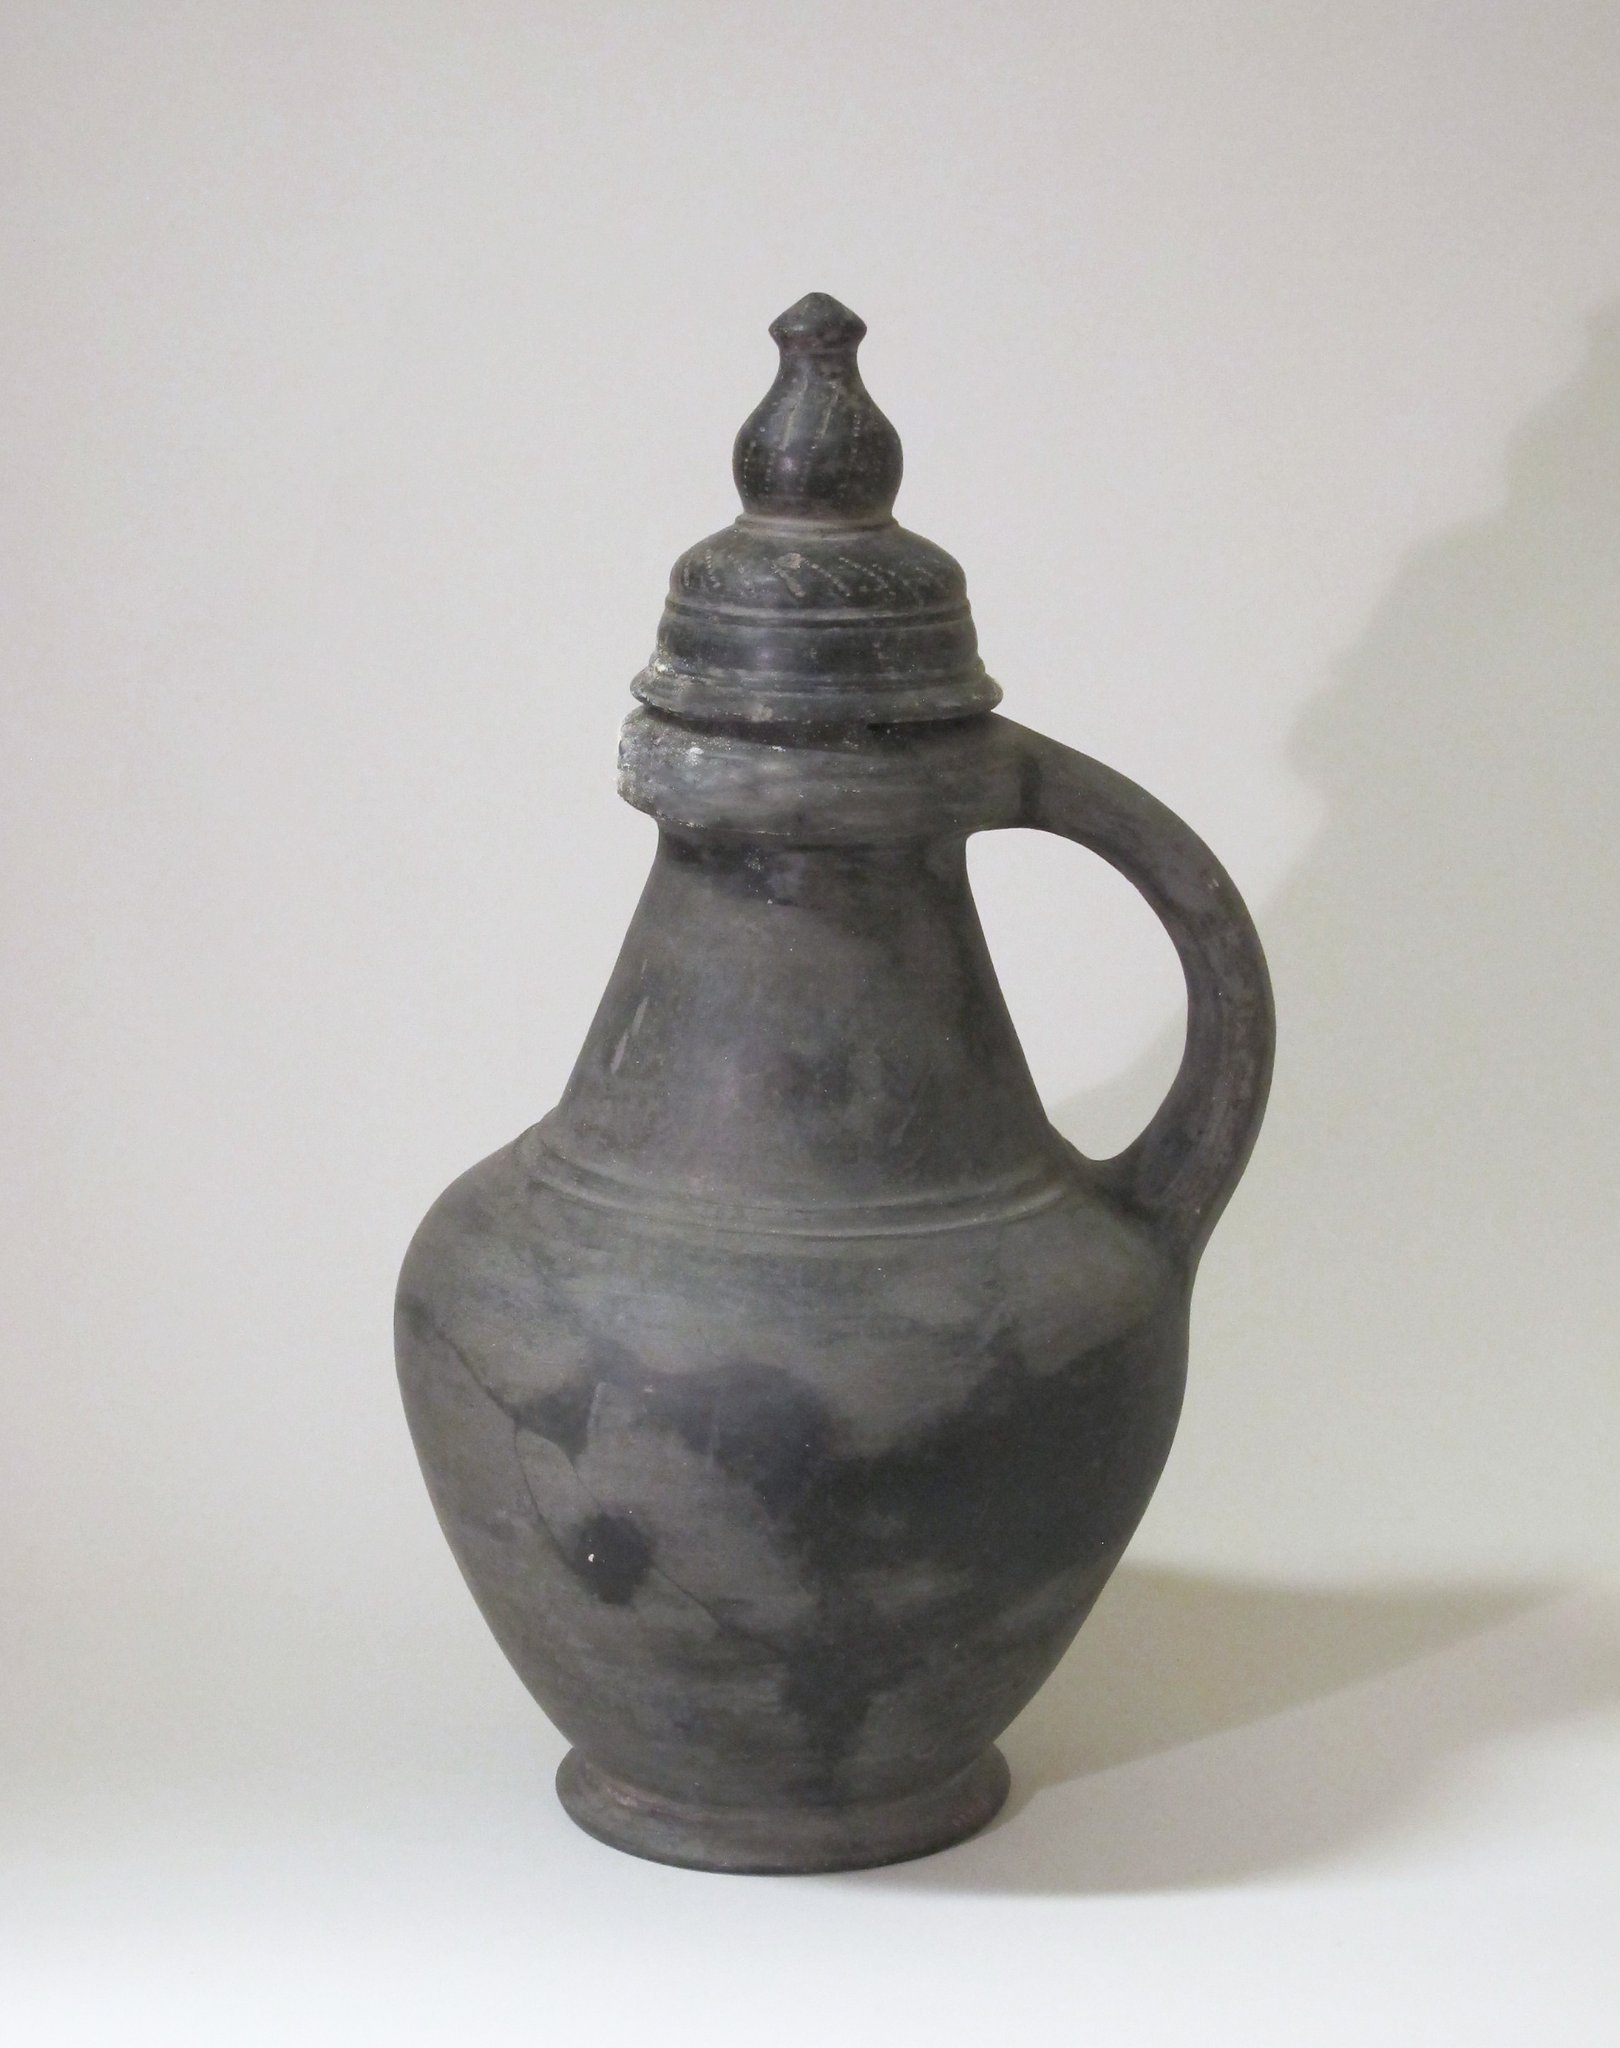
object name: jug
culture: etruscan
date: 567-535 BCE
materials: terracotta